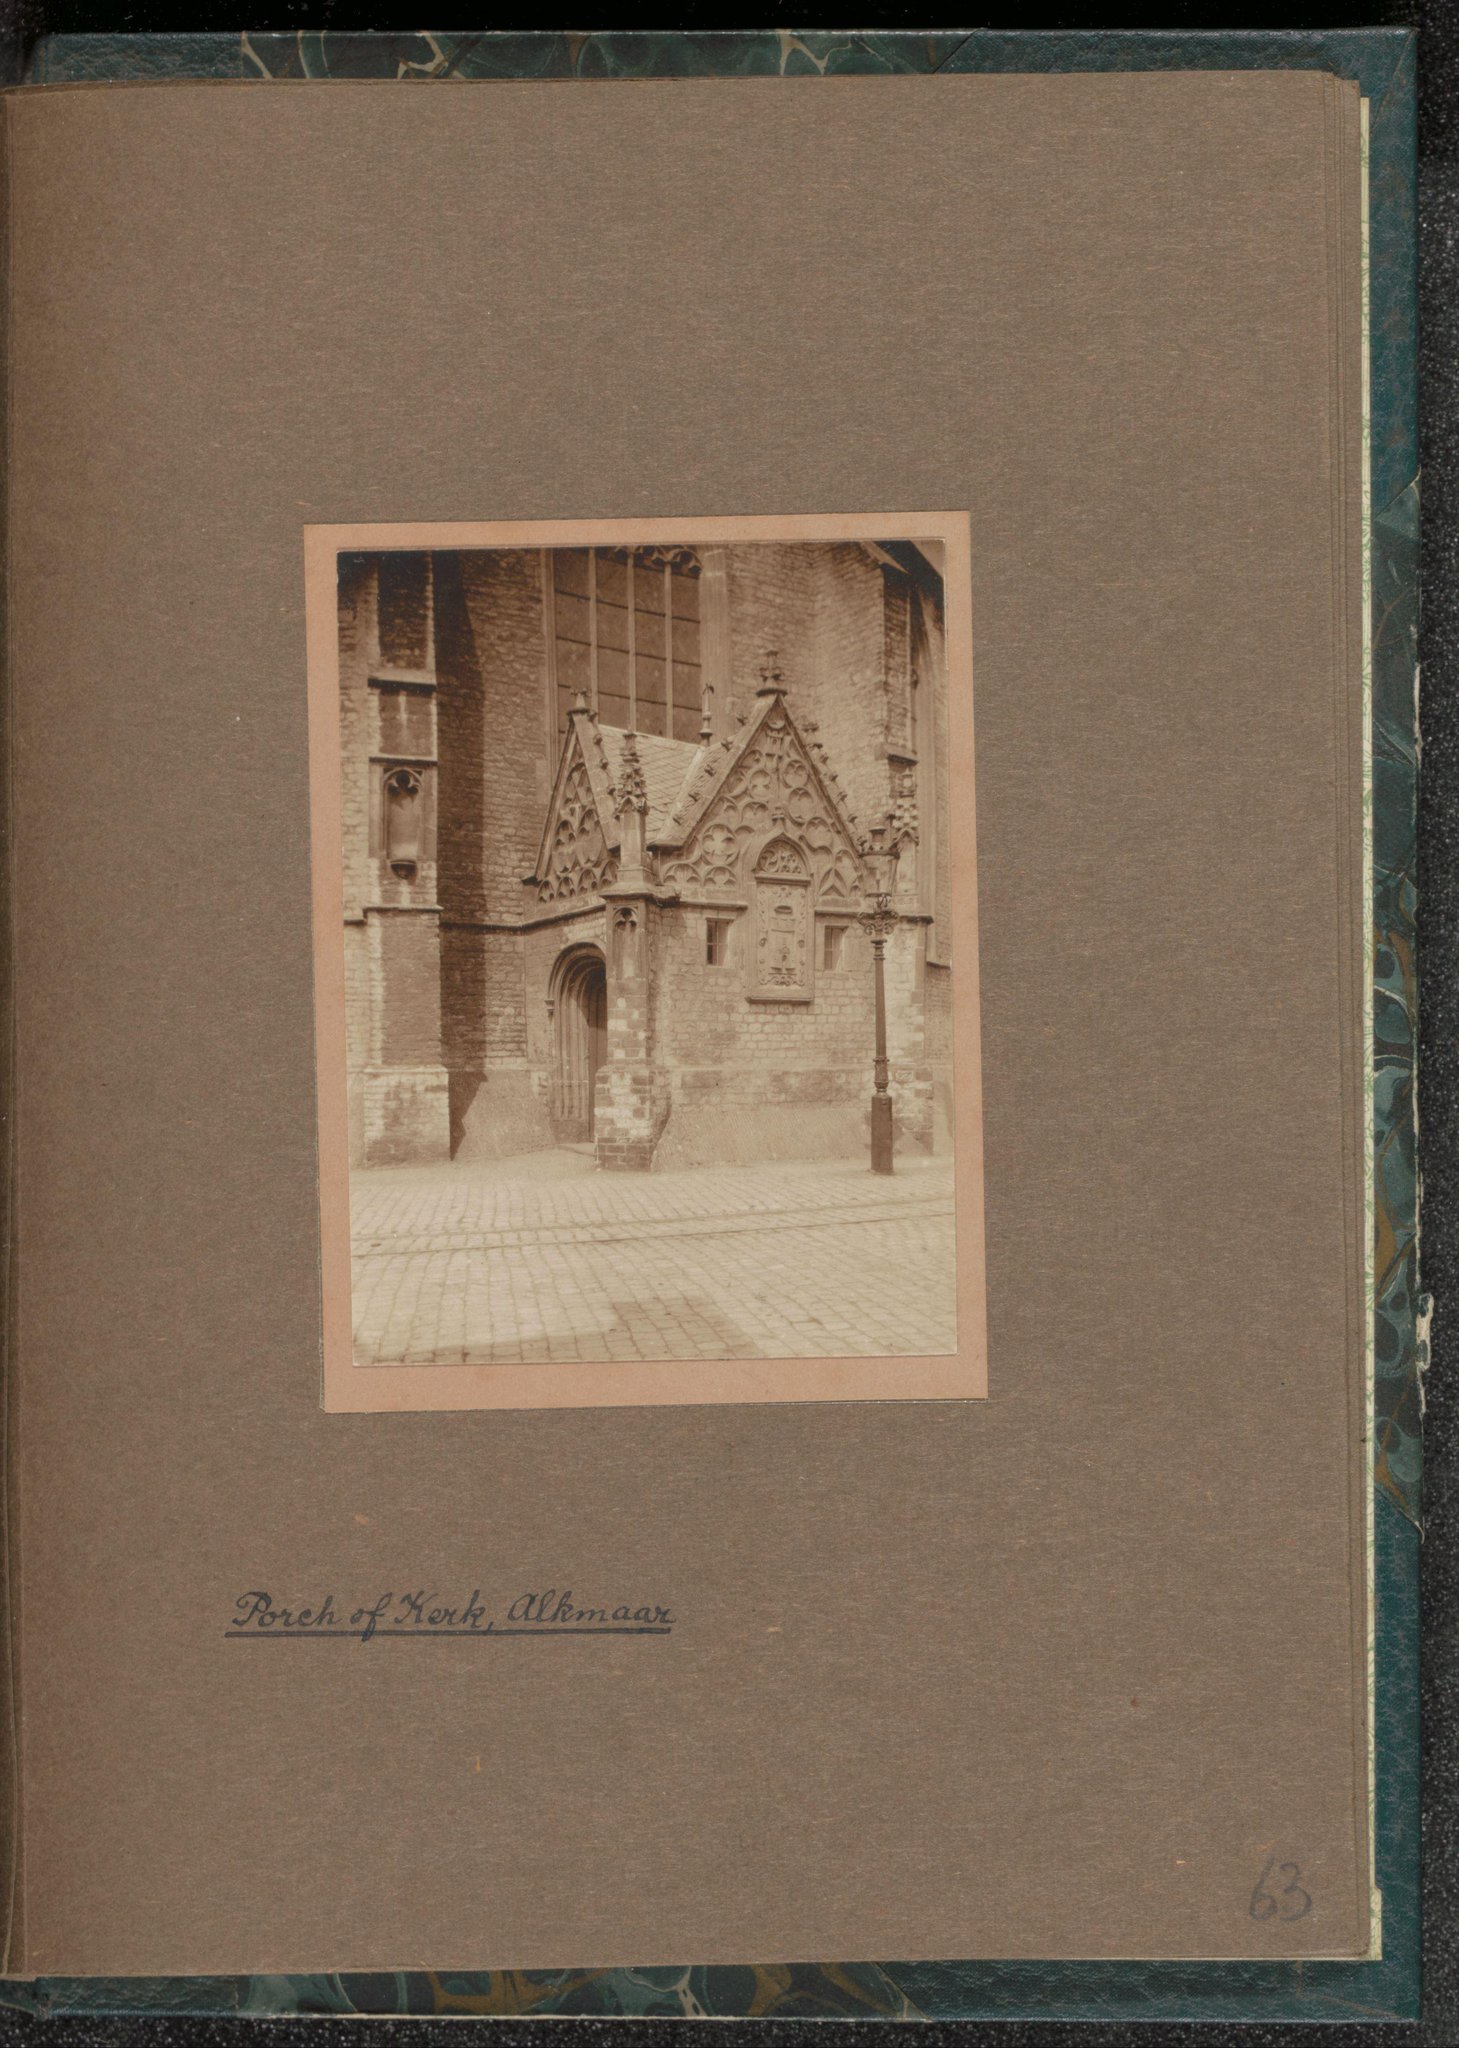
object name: photograph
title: Porch of Kerk Alkmaar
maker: Anonymous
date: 1912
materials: photographic support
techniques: gelatin silver print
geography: alkmaar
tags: parts of church exterior and annexes: porch, gate, entrance, travelling; tourism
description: Onderdeel van Fotoalbum van de excursie naar Nederland van de Britse amateurfotografenvereniging P.C.U.K.